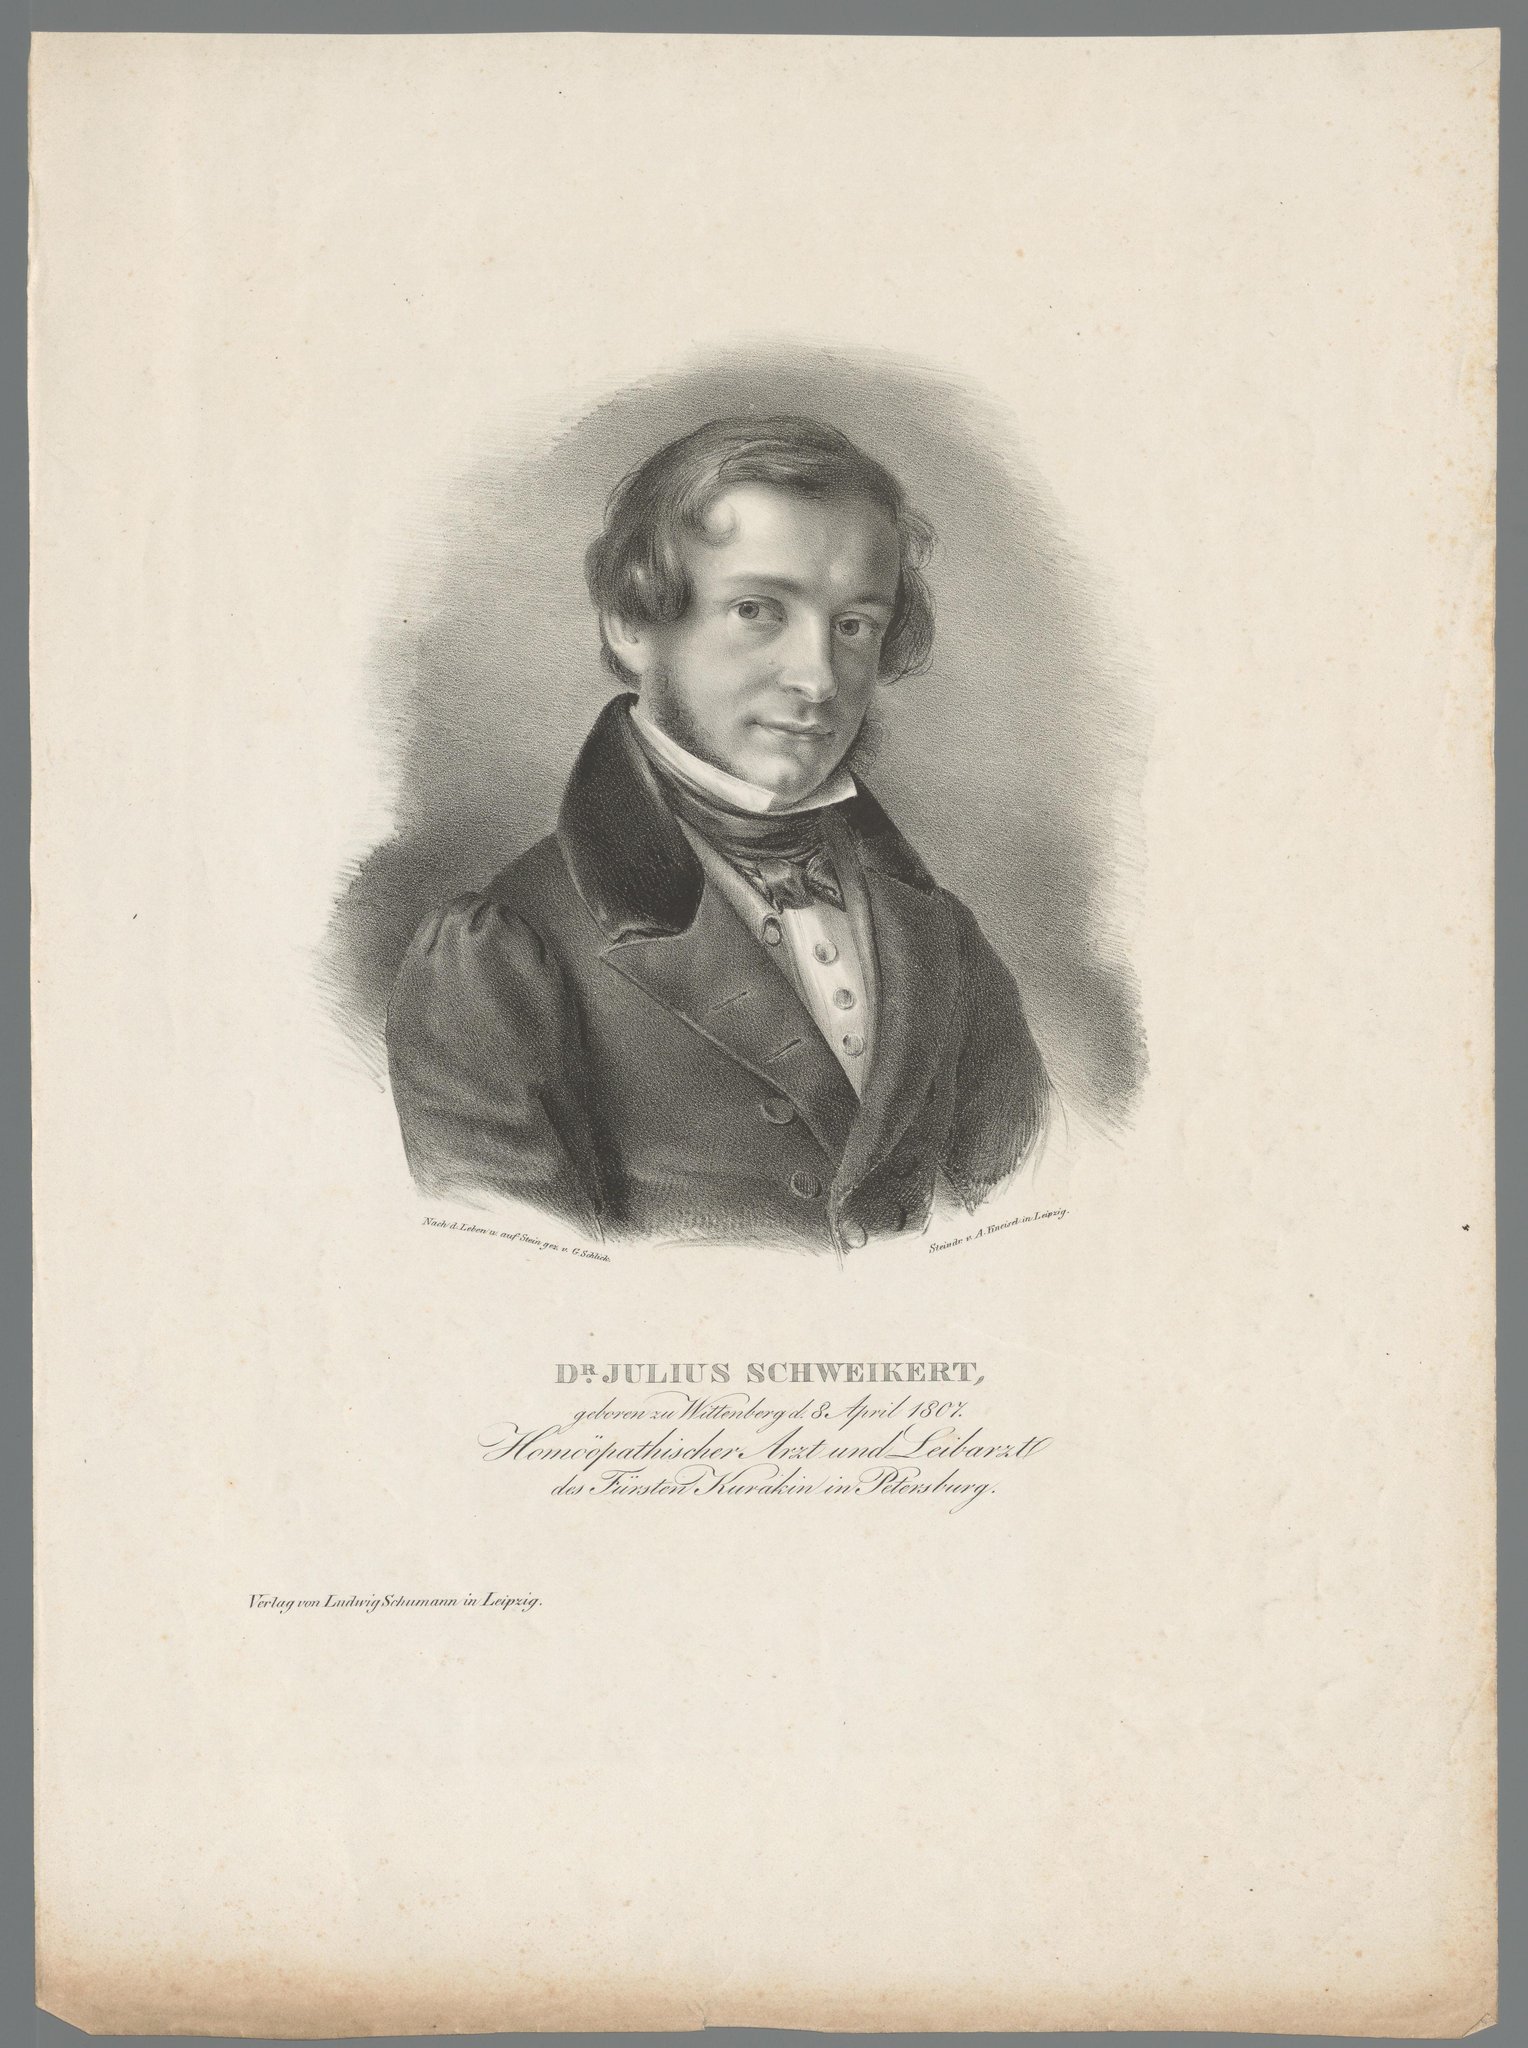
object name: print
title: Portret van Julius Schweikert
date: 1814-1869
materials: paper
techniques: lithograph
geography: leipzig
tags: historical persons, physician, doctor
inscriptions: collector's mark: Lugt 2228